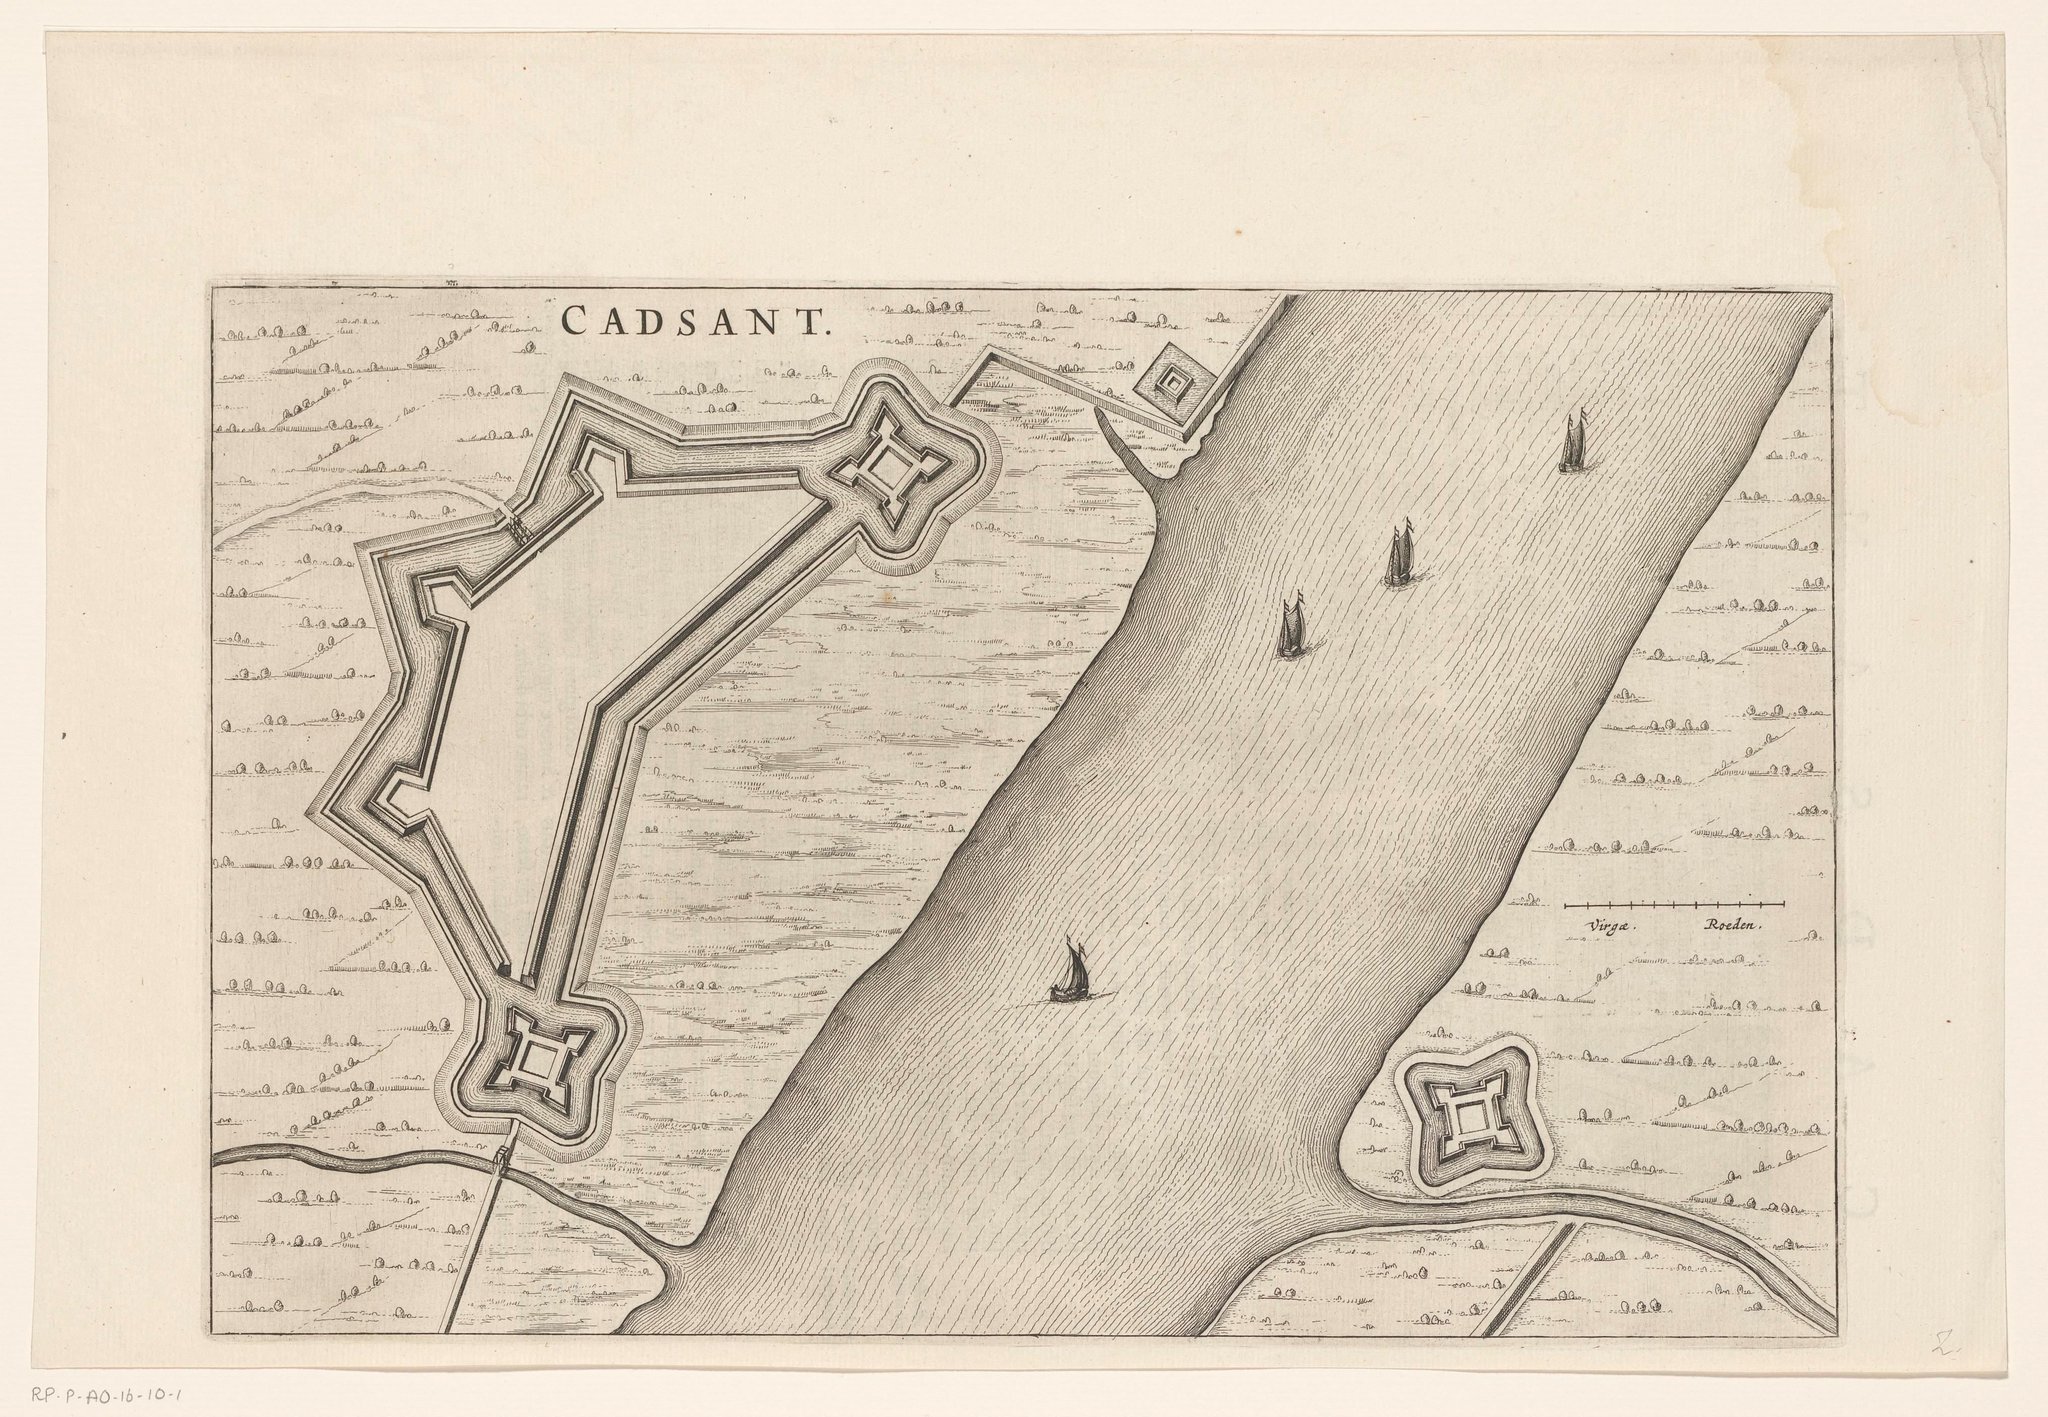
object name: print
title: Vestingplattegrond van Cadzand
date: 1652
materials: paper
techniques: engraving, etching, letterpress printing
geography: amsterdam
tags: fortified city, maps of cities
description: Prent gebruikt in: Blaeu, Johannes Willemszoon. Novum ac magnum theatrum urbium Belgicae (...). 2 delen. 3e druk. Amsterdam: Johannes Willemszoon Blaeu, 1652, dl. 1.